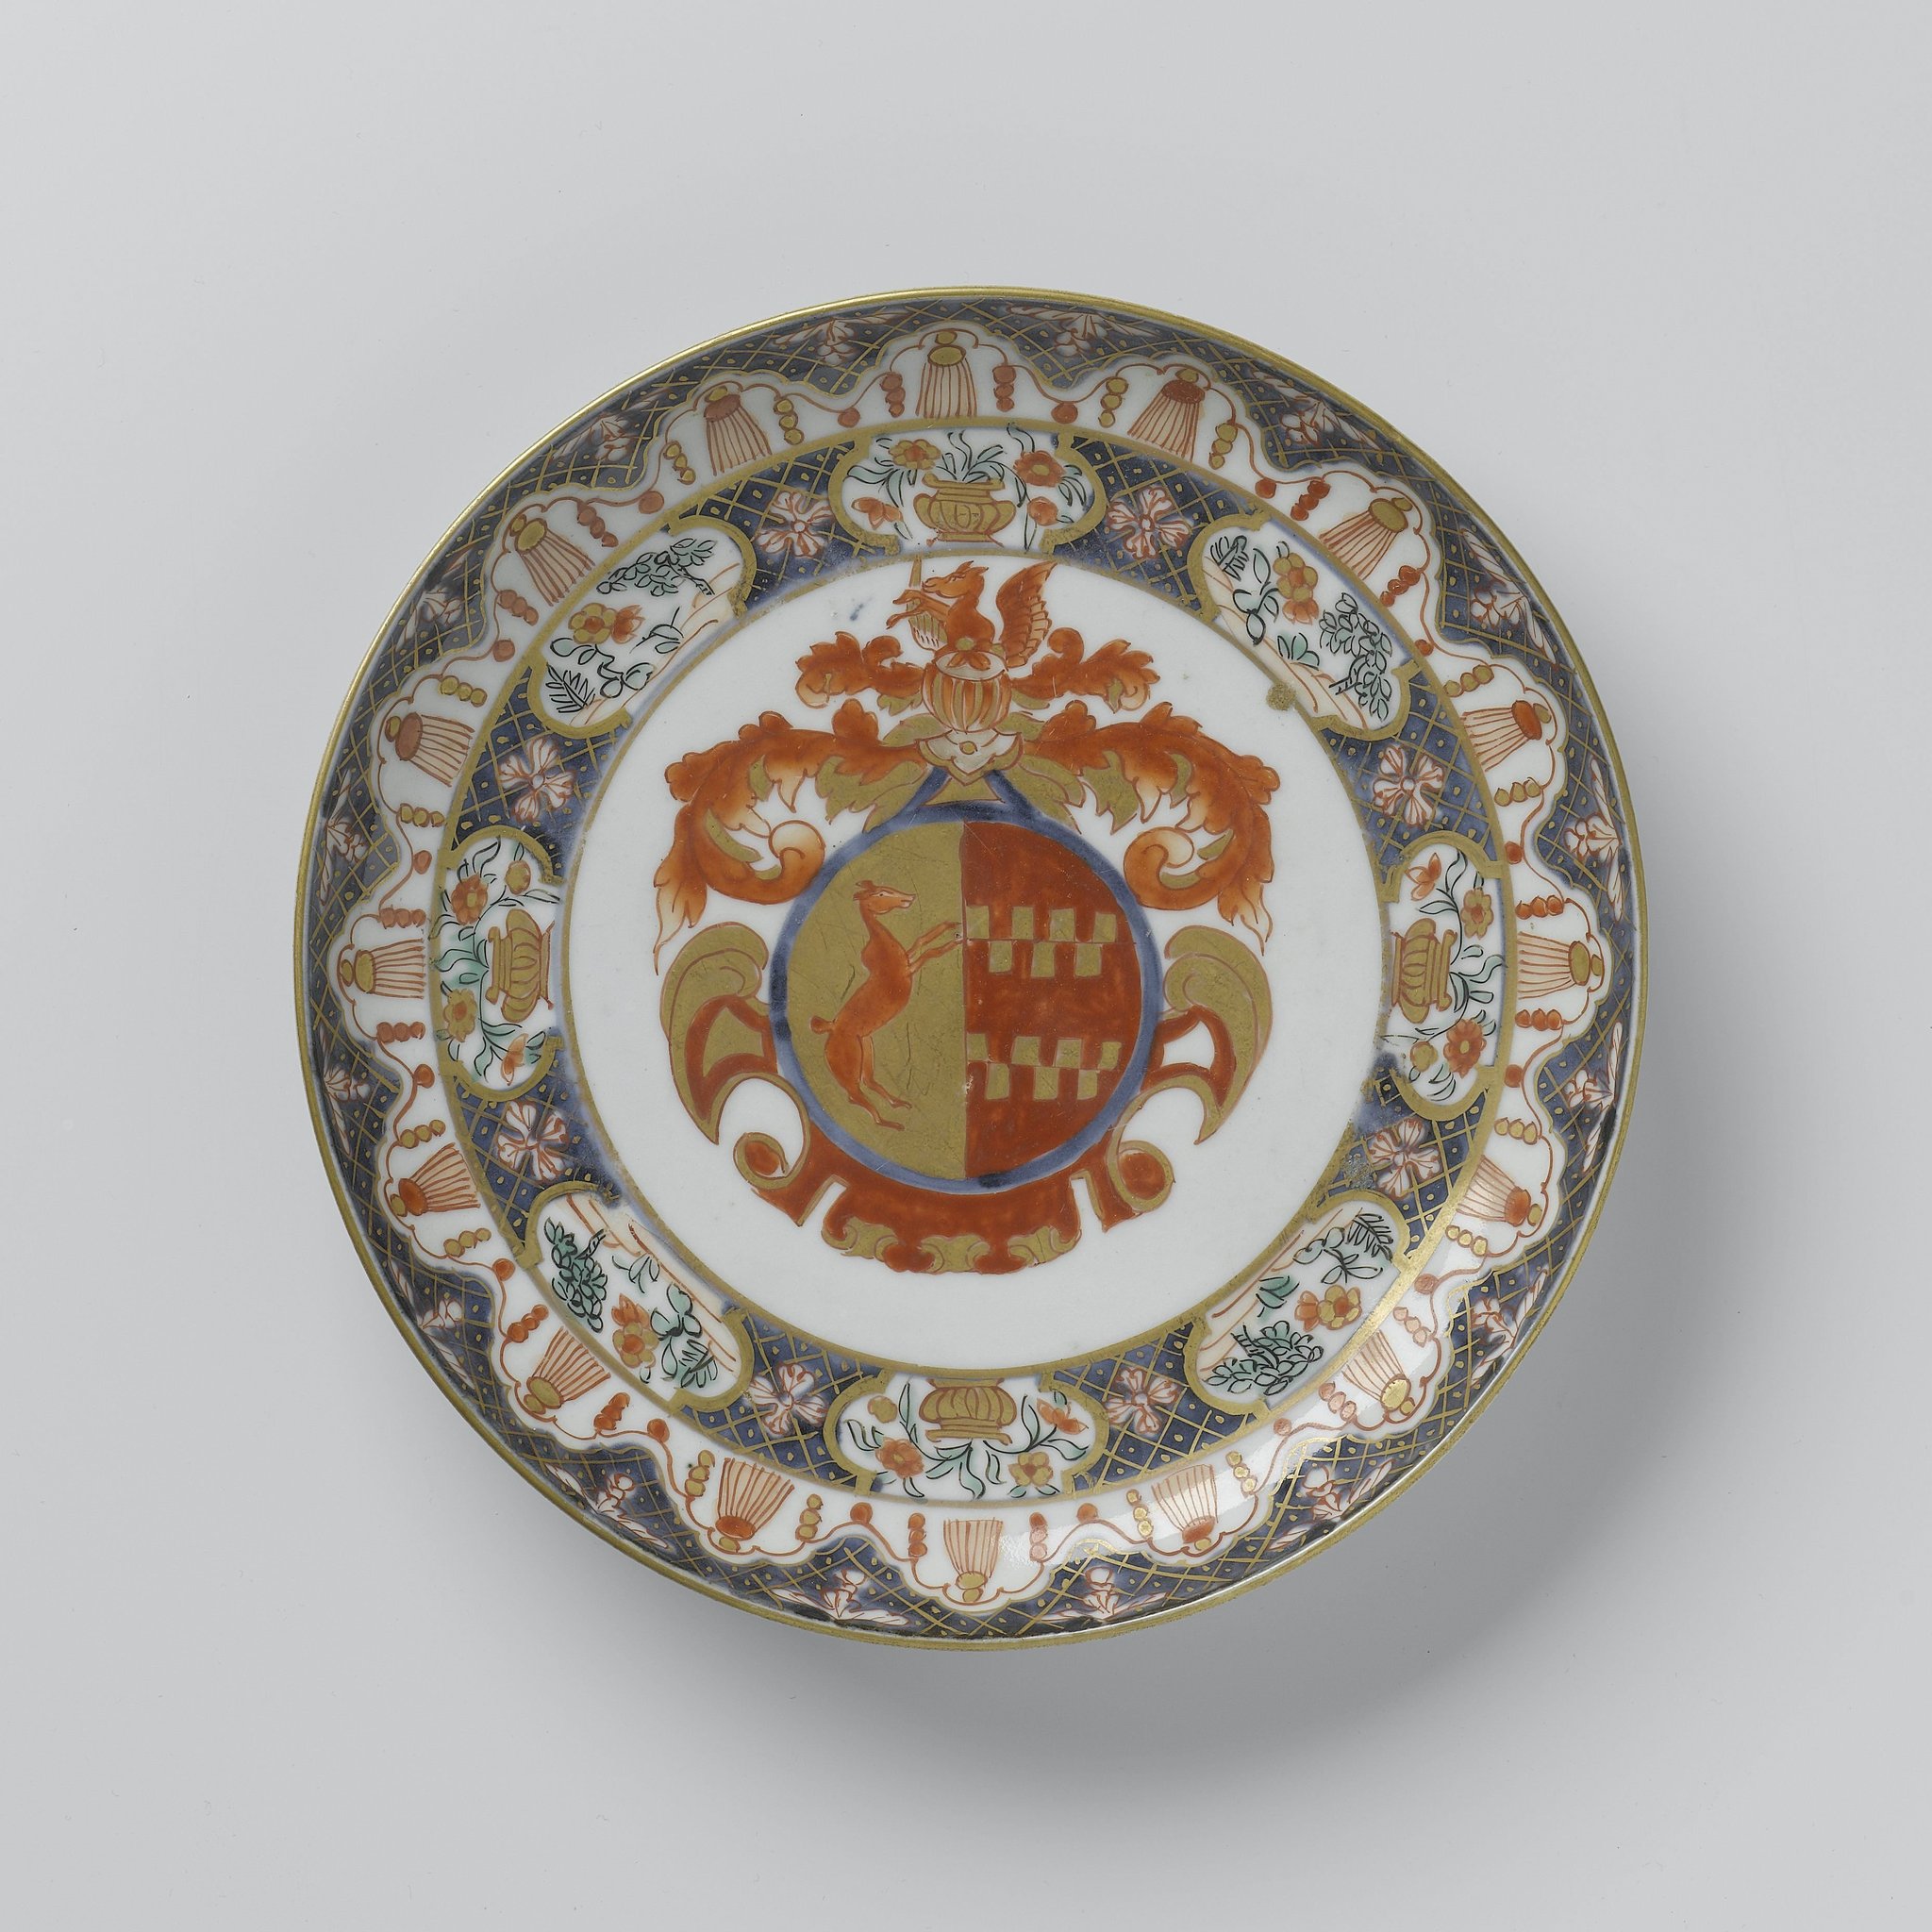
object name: dish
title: Saucer-dish with the arms of Van Buren and two ornamental borders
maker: Anonymous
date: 1700-1724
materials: cobalt, glaze, gold, paint, porcelain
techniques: firing, gilding, turning, vitrification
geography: japan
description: Schaal van porselein, beschilderd in onderglazuur blauw en op het glazuur rood, groen, zwart en goud. Op het plat het familiewapen van Van Buren met links een windhond tegen een gouden achtergrond en rechts twee keer zeven gouden rechthoeken op een rode achtergrond. Het helmteken is een windhond met vleugels omgeven door acanthusbladeren. Om het medaillon een band met servetwerk met een gestileerde bloem, onderbroken door cartouches met een landschap of een bloemenvaas. De rand met een band met kwasten en een band met bladeren op servetwerk. Vier proenen op de onderzijde. Wapenporselein in Imari. Arita.